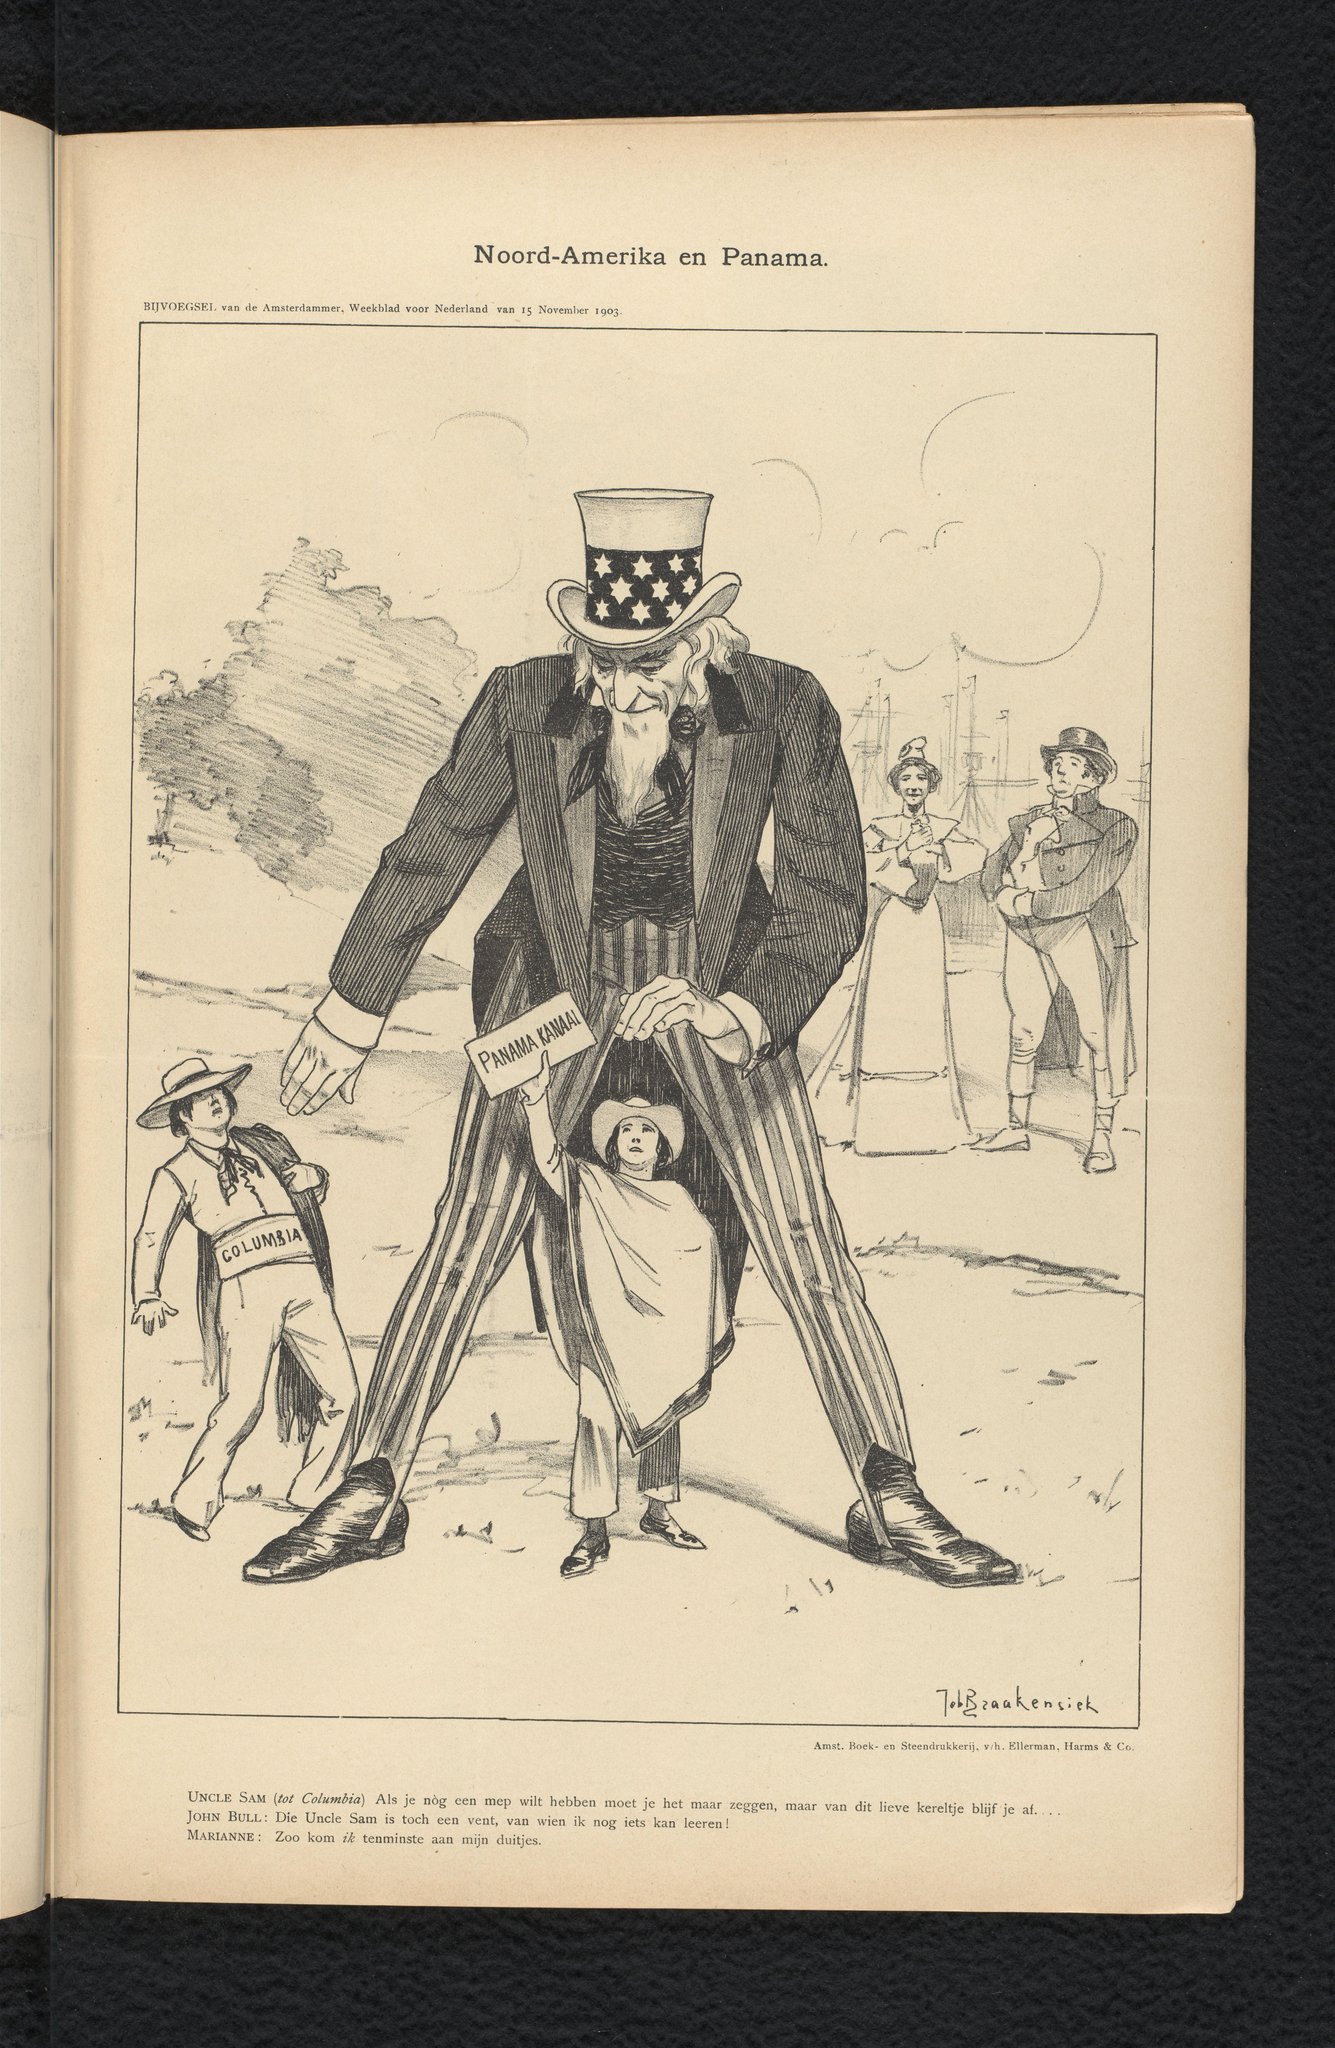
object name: cartoon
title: Noord-Amerika en Panama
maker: johan braakensiek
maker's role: draughtsman, print maker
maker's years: 1858-1940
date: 1903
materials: paper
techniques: lithograph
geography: netherlands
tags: personifications of countries, nations, states, districts, etc., political caricatures and satires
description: Uncle Sam (Verenigde Staten) beschermt het kereltje Panama / Panamakanaal tegen het kereltje Colombia. Marianne (Frankrijk) en John Bull (Engeland) kijken goedkeurend toe.